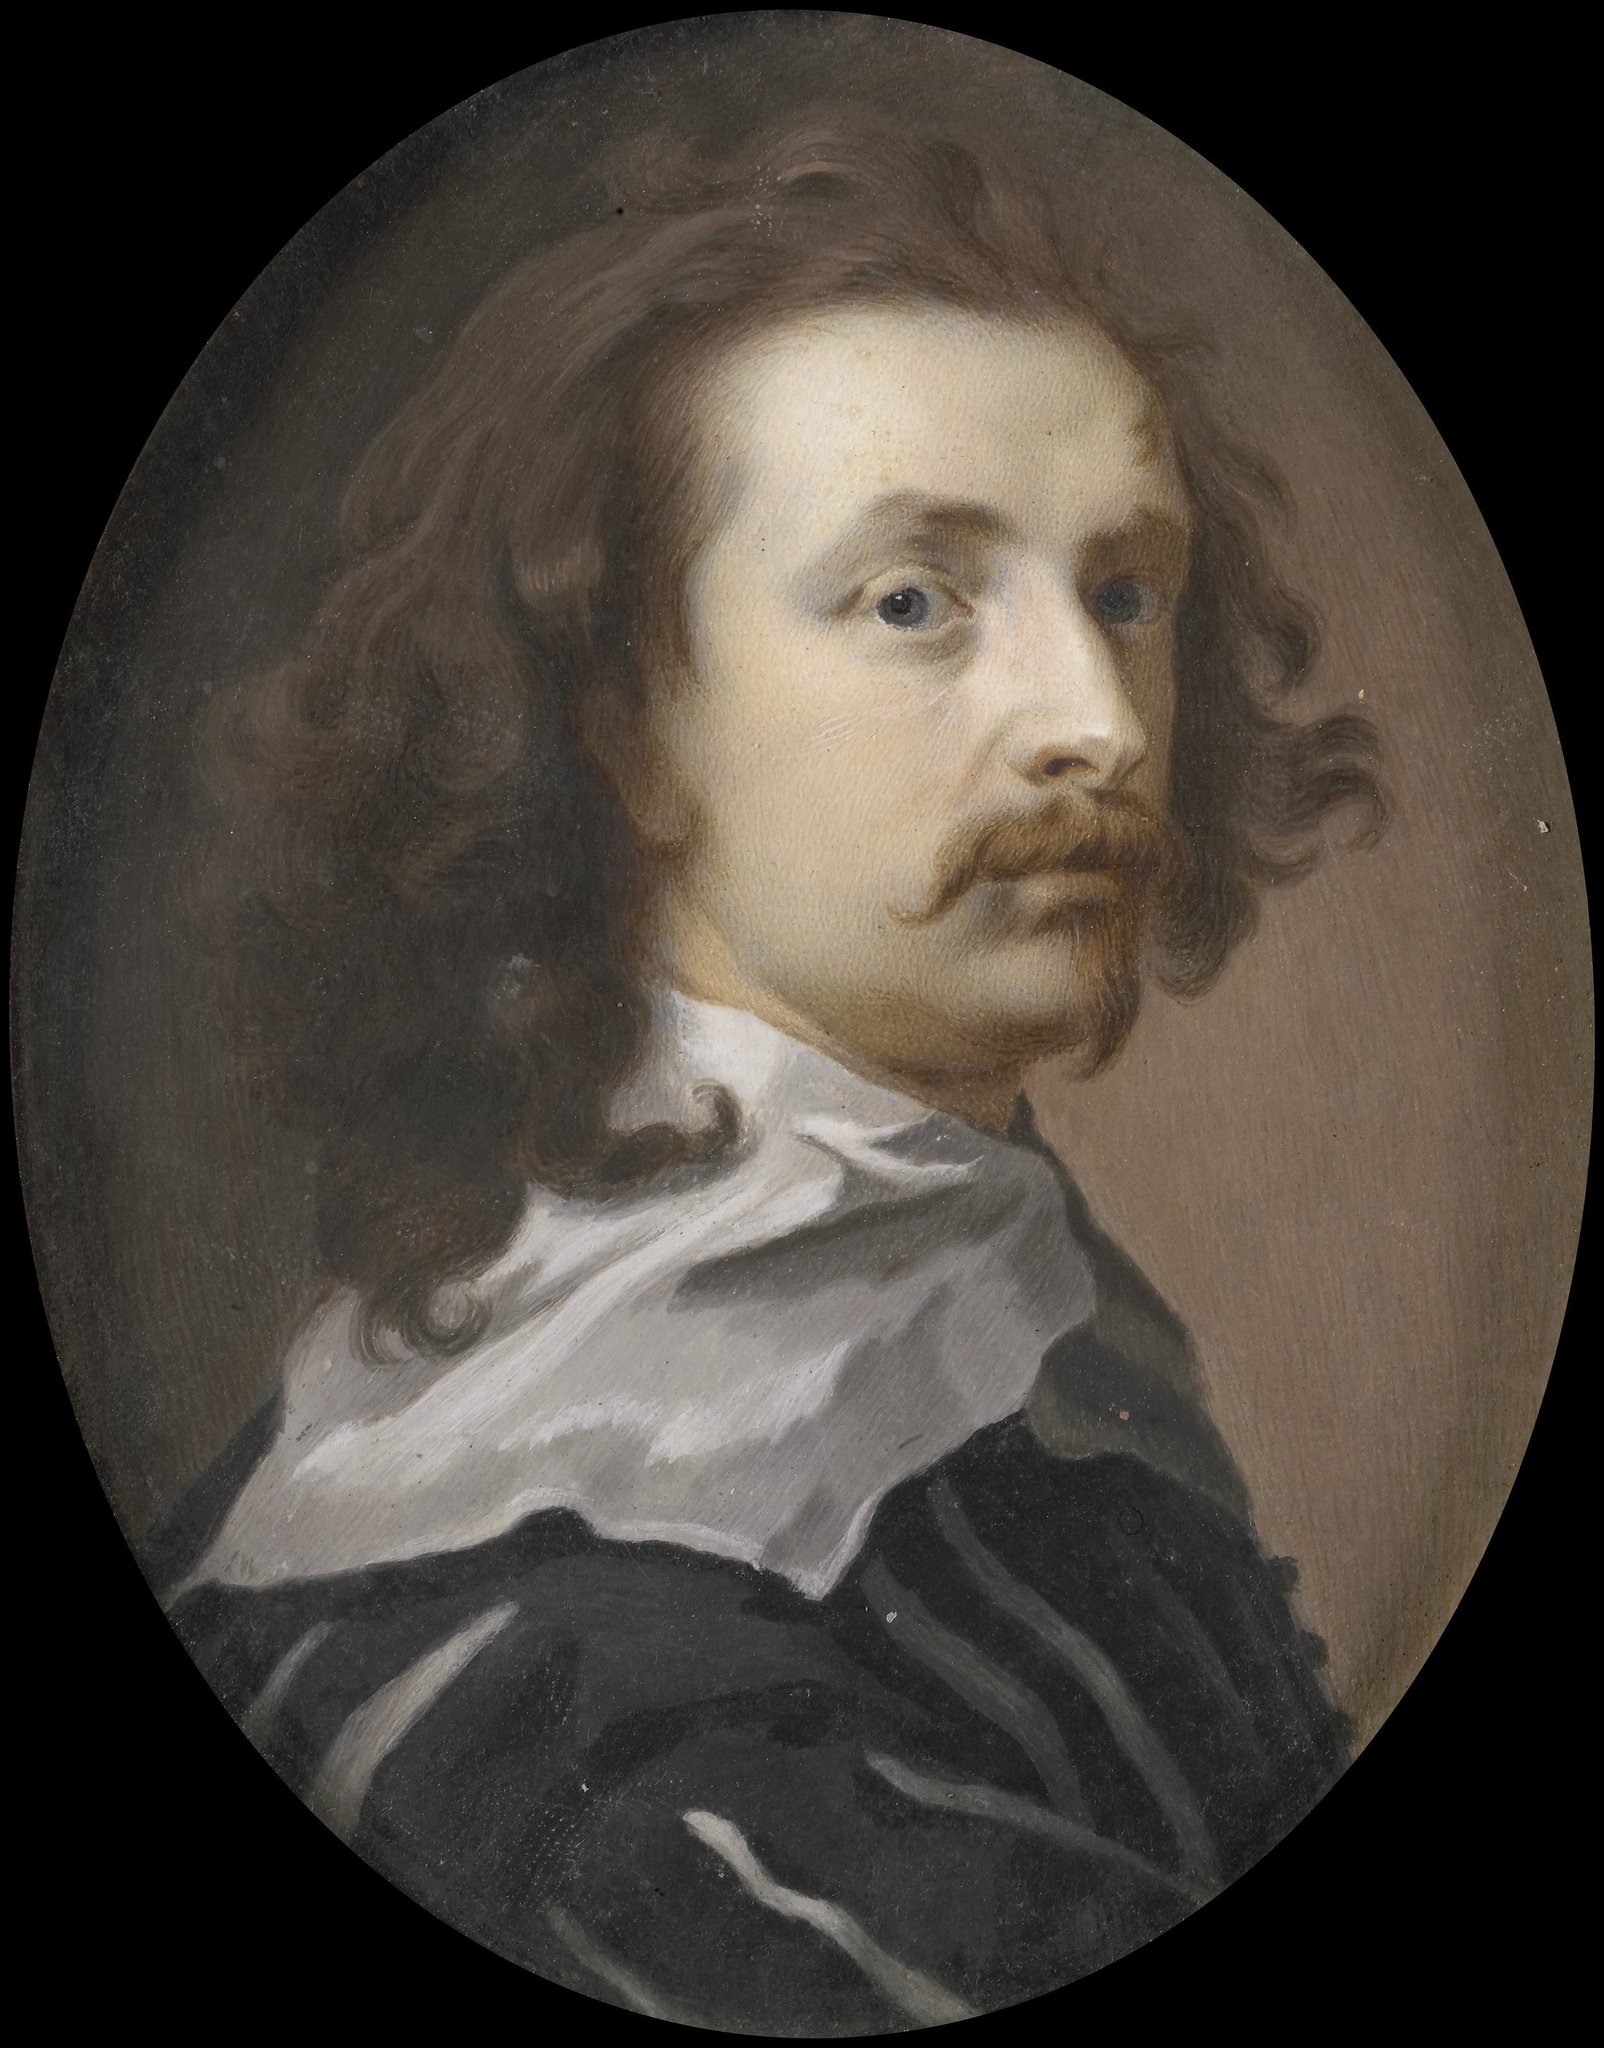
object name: painting, miniature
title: Anthony van Dyck (1599-1641). Schilder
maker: christian richter (i)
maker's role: painter, print maker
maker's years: 1587-1667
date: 1711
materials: cardboard, glass, metal, oil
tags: antwerp, london, painter, print maker, draughtsman, anthony van dyck, portrait, self-portrait of painter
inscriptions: inscription: ‘C. Richter pinxit 1711’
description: Portret van Anthony van Dyck (1599-1641). Schilder. Buste, naar rechts. Naar Anthony van Dyck. Onderdeel van de collectie portretminiaturen.